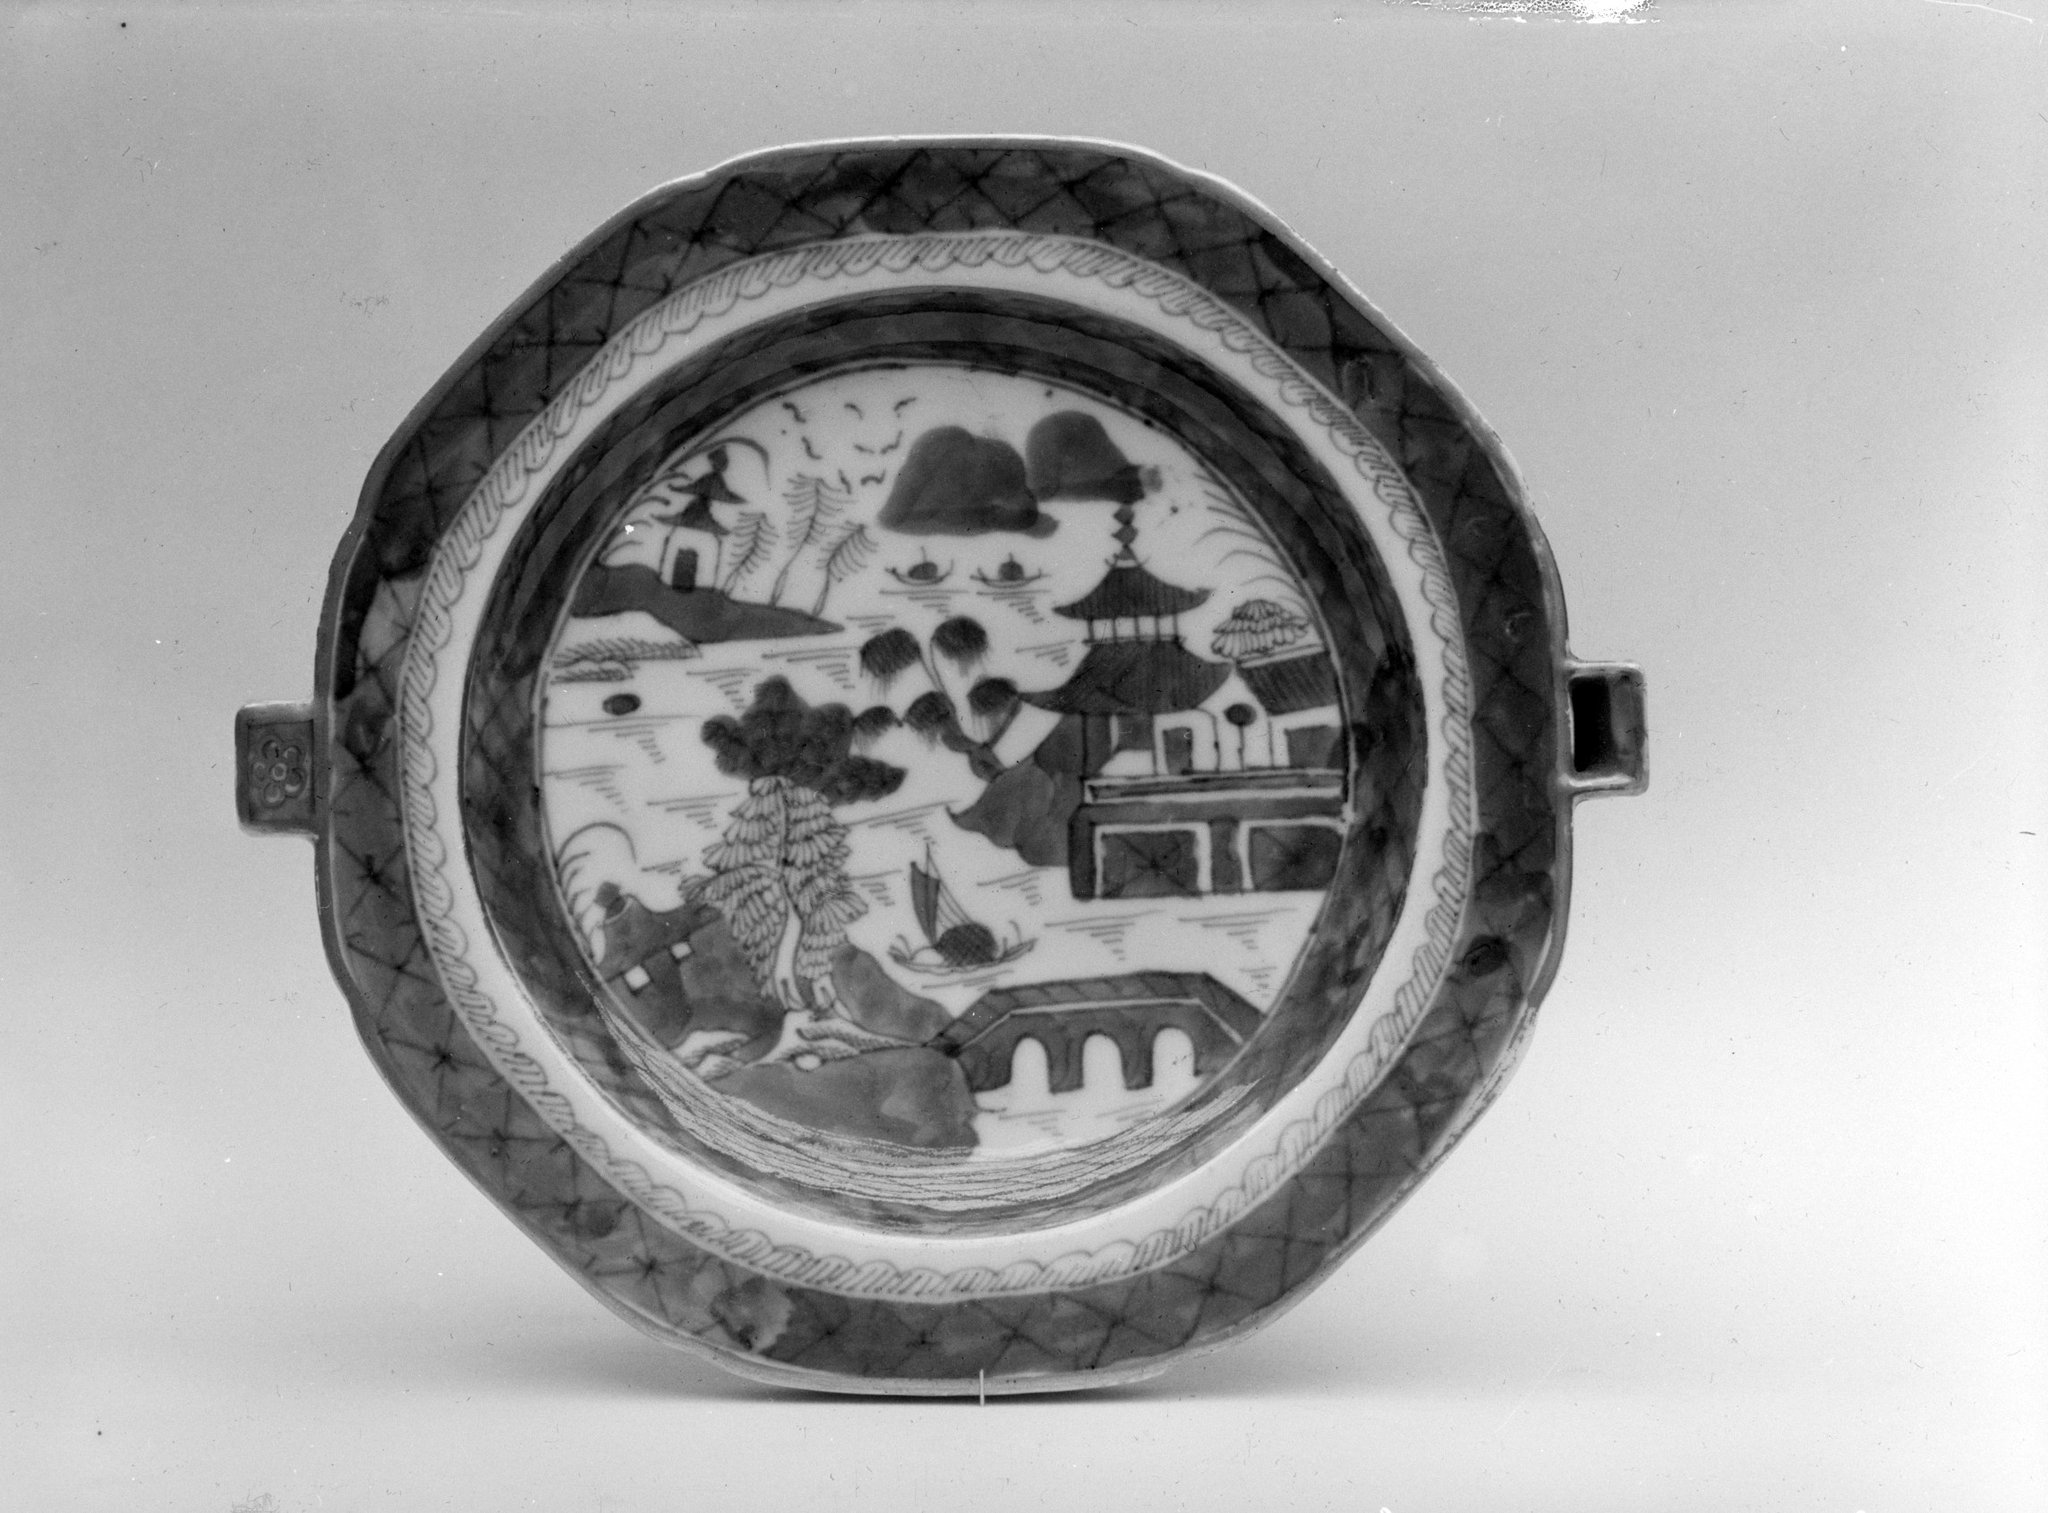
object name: hot water plate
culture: chinese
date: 1800-1830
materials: porcelain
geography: china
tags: landscapes,boats